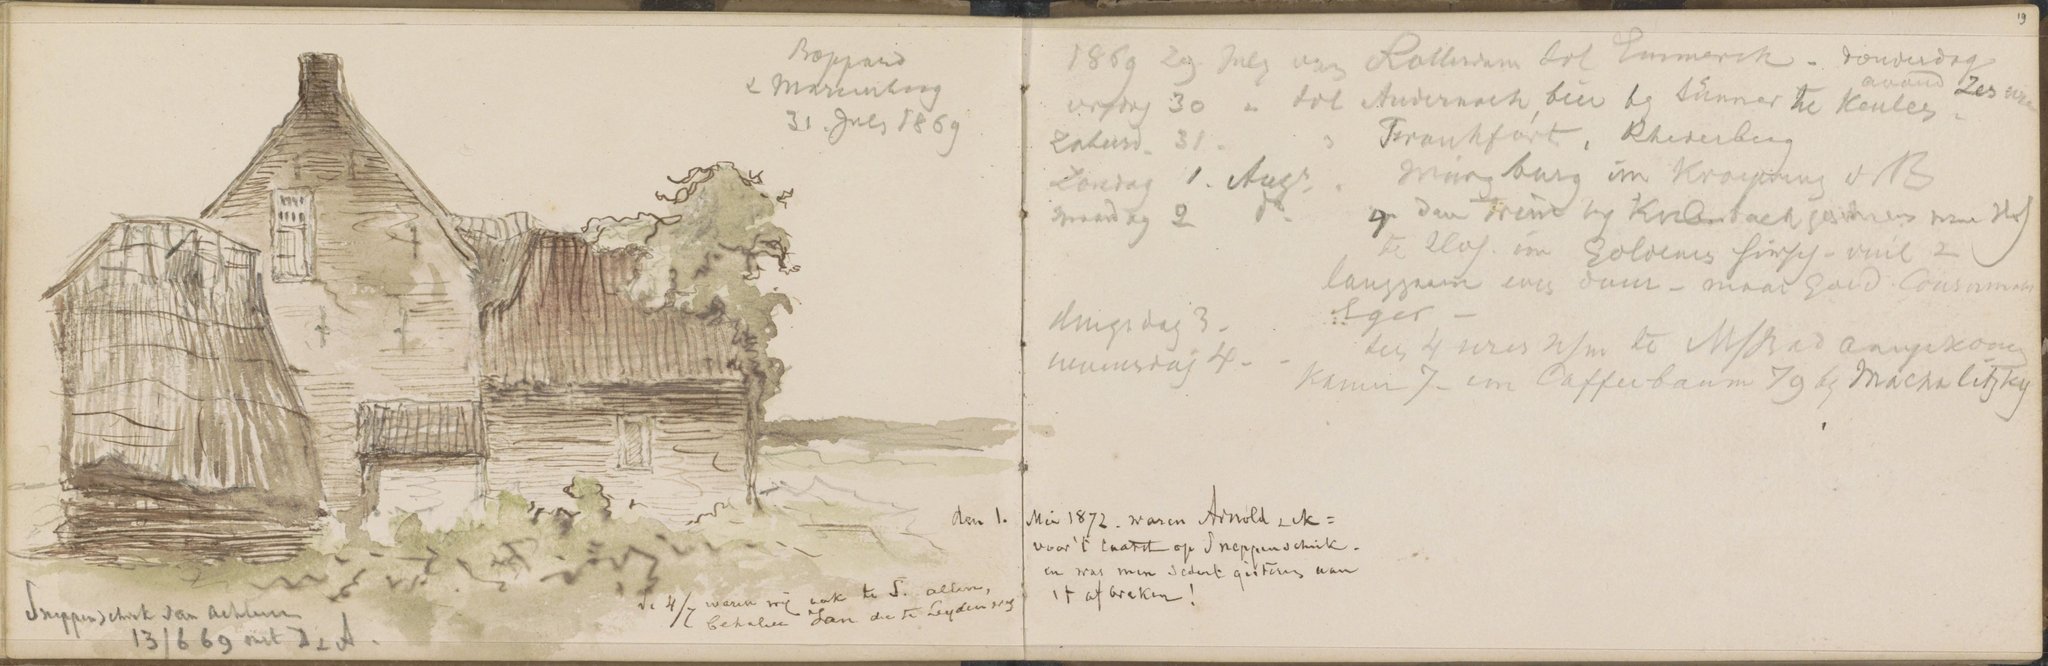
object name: sketchbook leaf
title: Achterzijde van het jachthuis Sneppenschrik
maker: johannes tavenraat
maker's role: draughtsman, painter, print maker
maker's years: 1809-1881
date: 1806-1869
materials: ink, paper, pencil, watercolor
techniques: brush, pen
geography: capelle aan den ijssel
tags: rural housing, e.g. country-house, villa, cottage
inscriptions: date and inscription: ‘Sneppenschrik van achteren/ 13/6 69 met A & d. / [...] & Marienberg/ 31. July 1869/ te 4/7 waren wij ook te S. aldus/ behalve Jan die te Leyden was’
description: Blad 18 verso uit een schetsboek met 48 bladen.